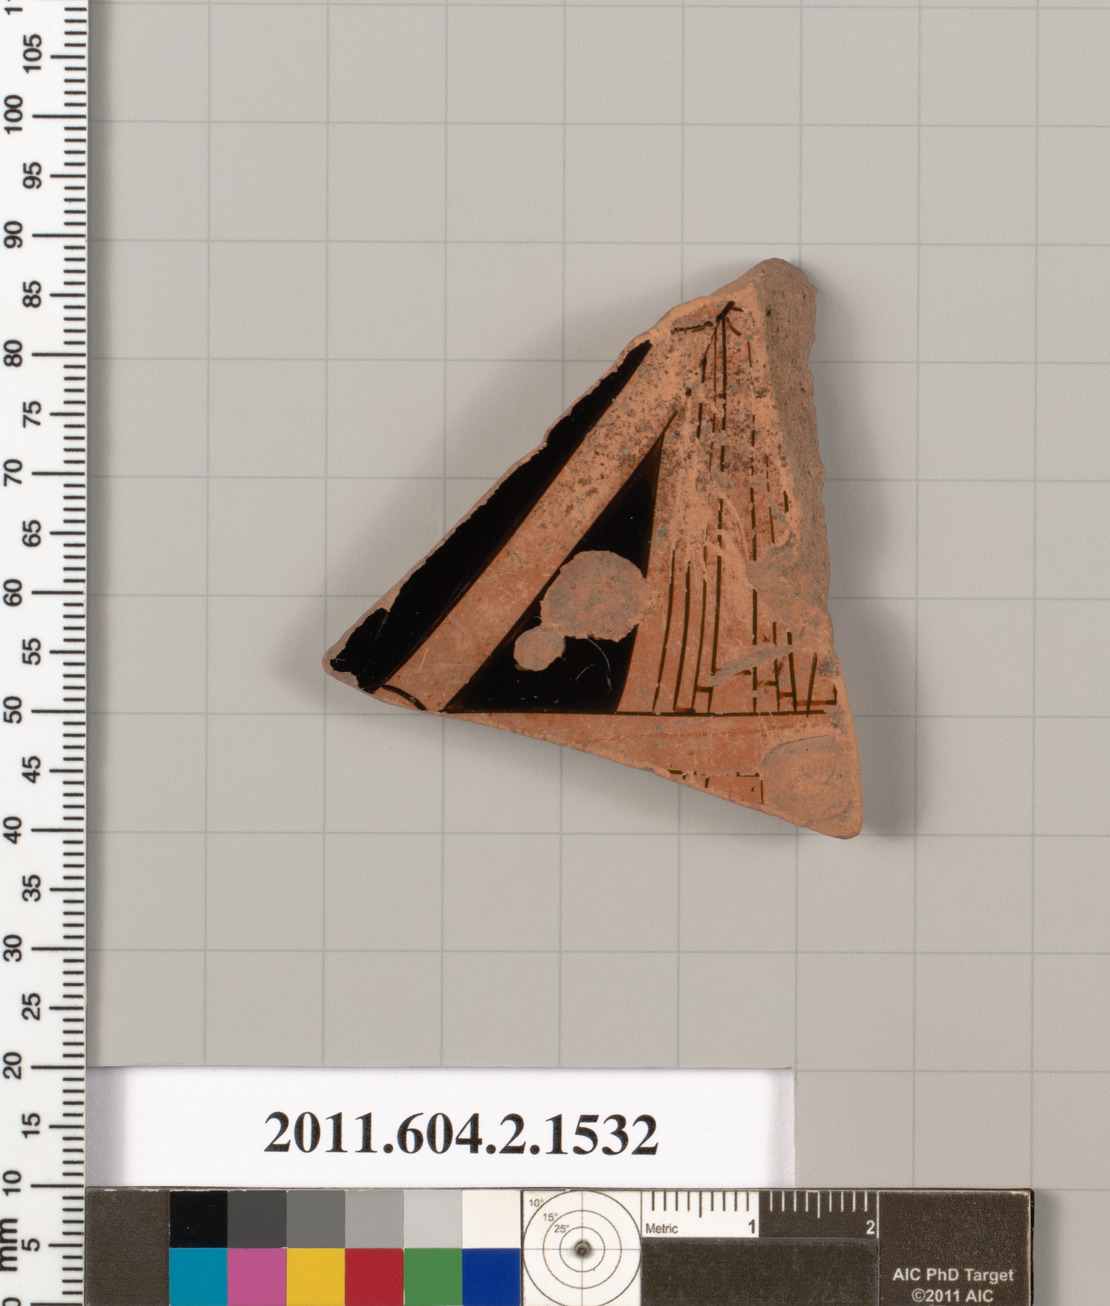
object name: skyphos fragment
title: Terracotta fragment of a skyphos (deep drinking cup)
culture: greek, attic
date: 490-480 BCE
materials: terracotta